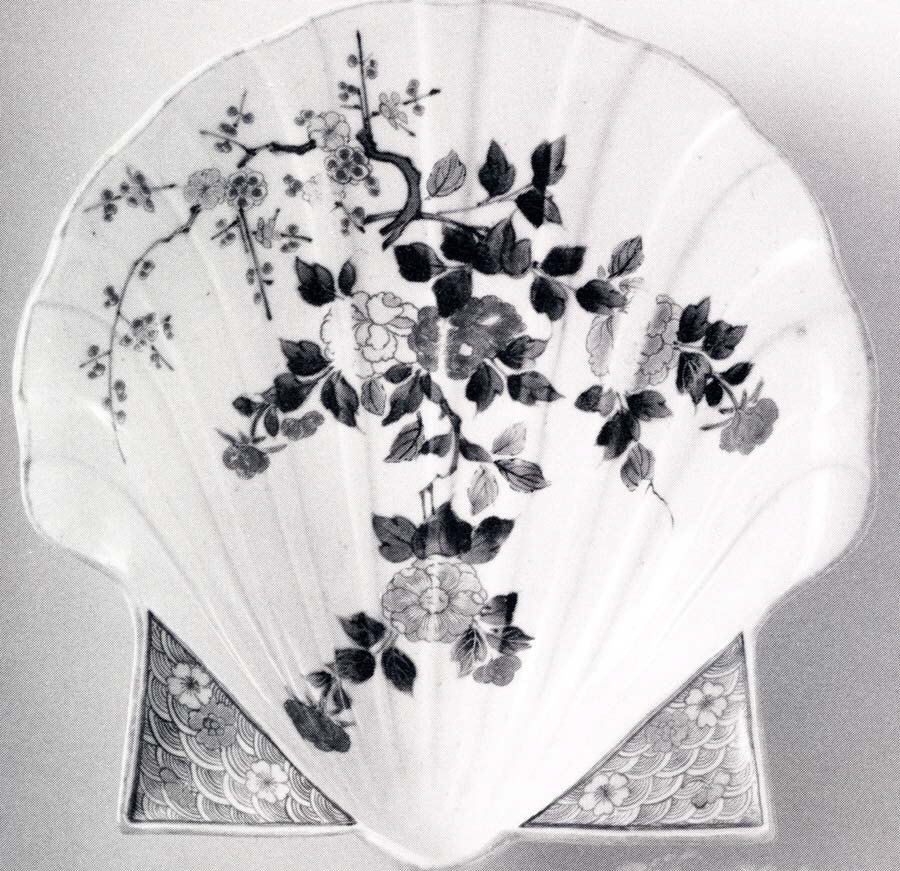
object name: dish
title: Dish in the Shape of a Shell with Floral Decoration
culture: japanese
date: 1601-1700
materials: enamel, porcelain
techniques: overglaze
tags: flowers,leaves